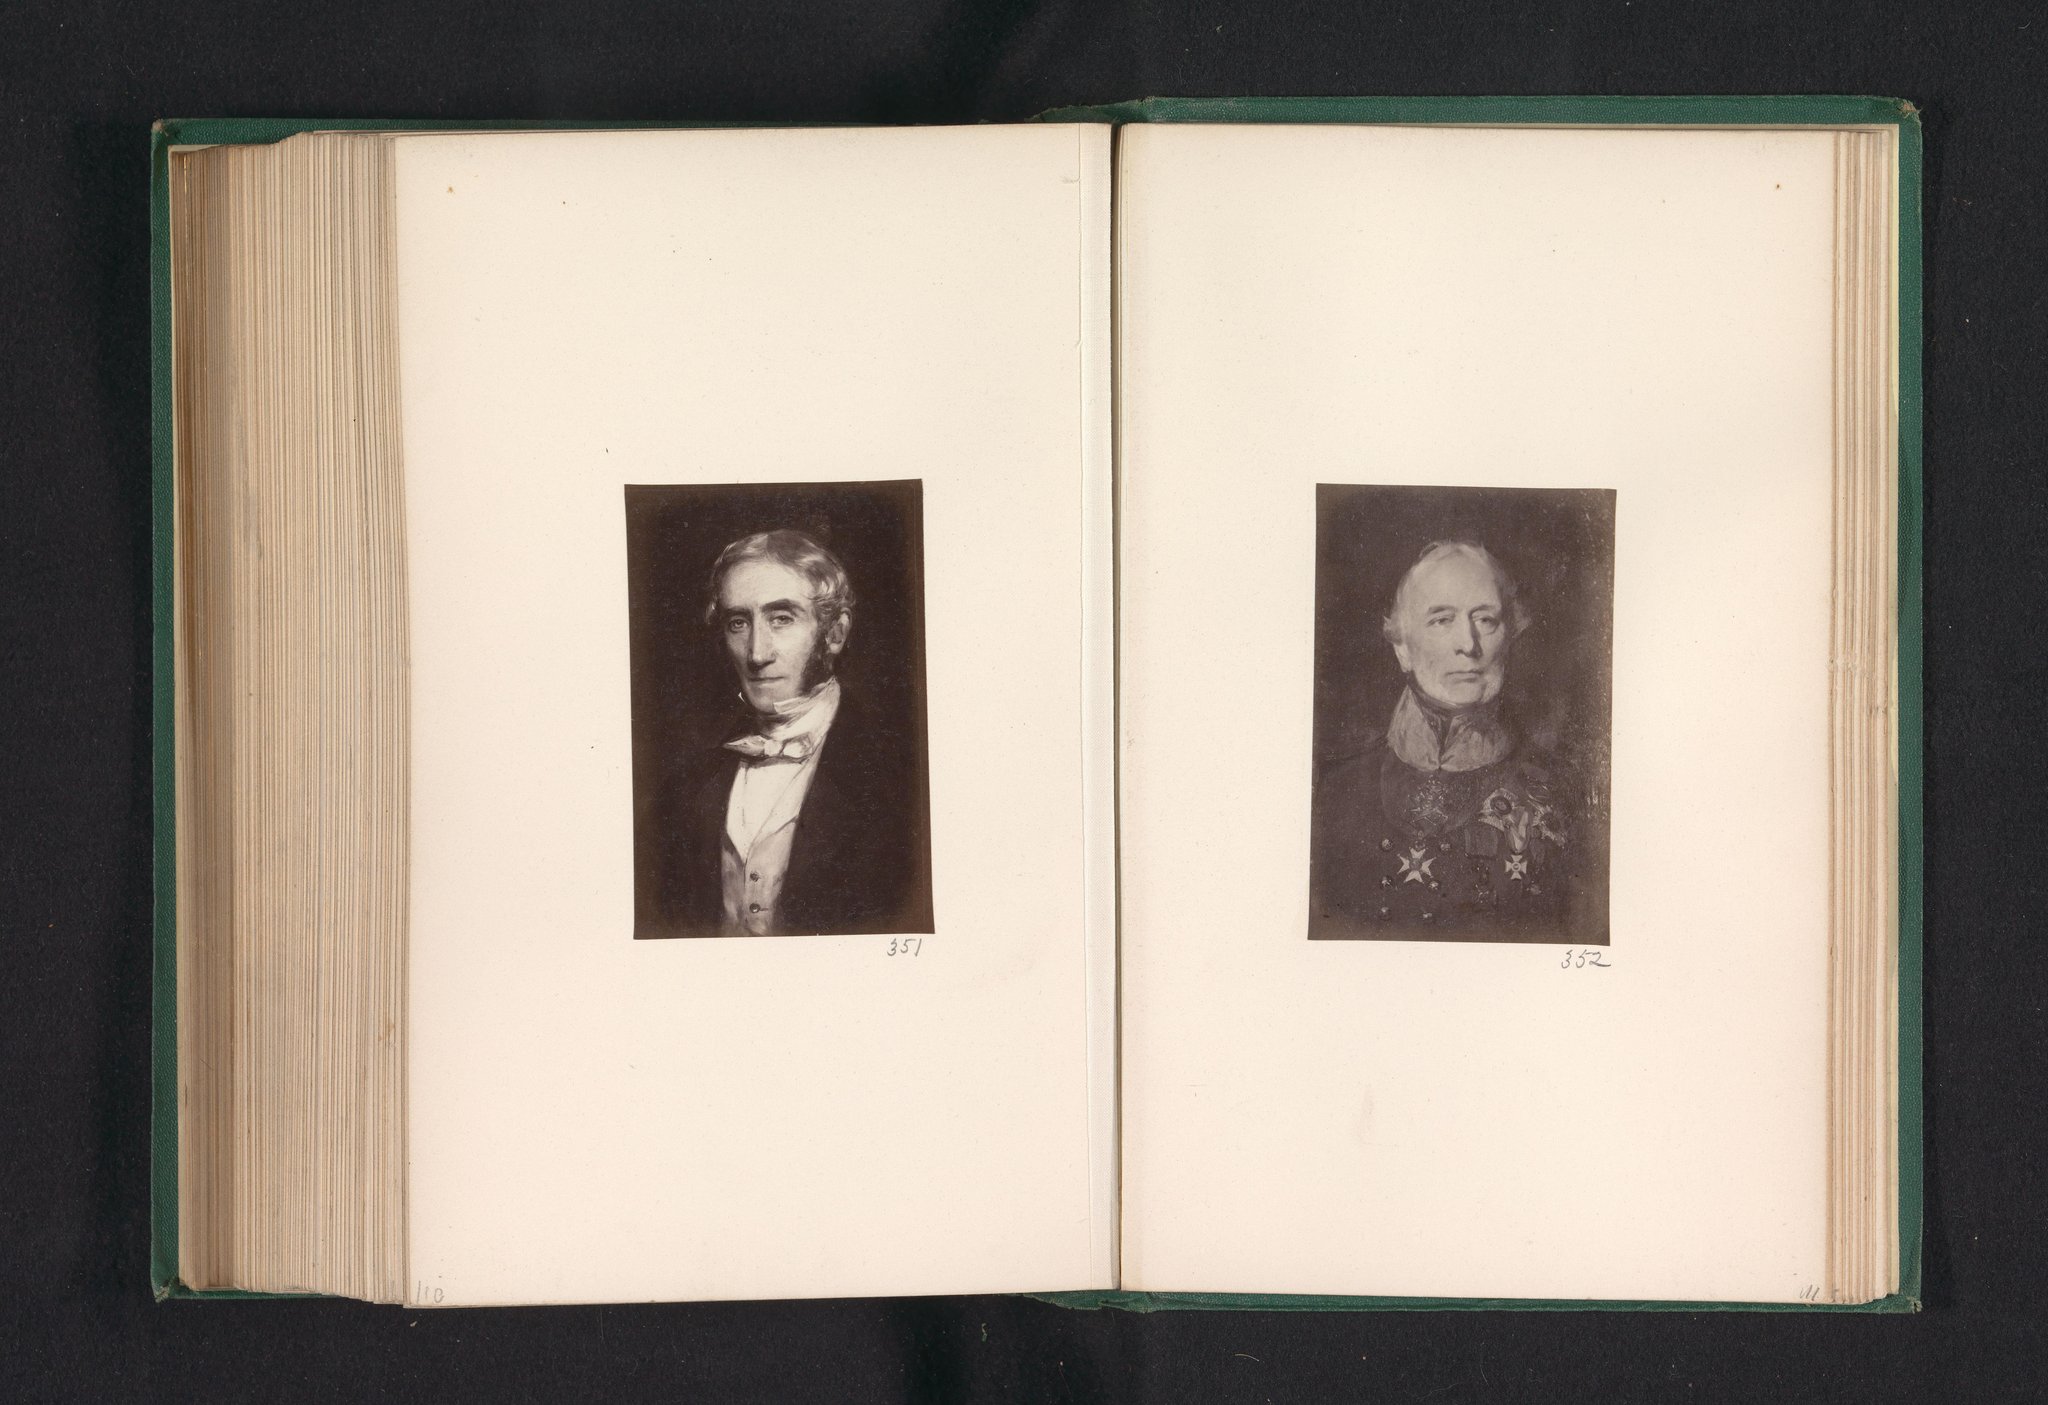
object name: photograph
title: Fotoreproductie van een schilderij, voorstellende een portret van Neil Douglas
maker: thomas annan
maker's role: fotograaf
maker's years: 1829-1887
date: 1863-1868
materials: photographic support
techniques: albumen print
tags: historical persons (portraits and scenes from the life) (+ (full) bust portrait)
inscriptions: number: ‘352’